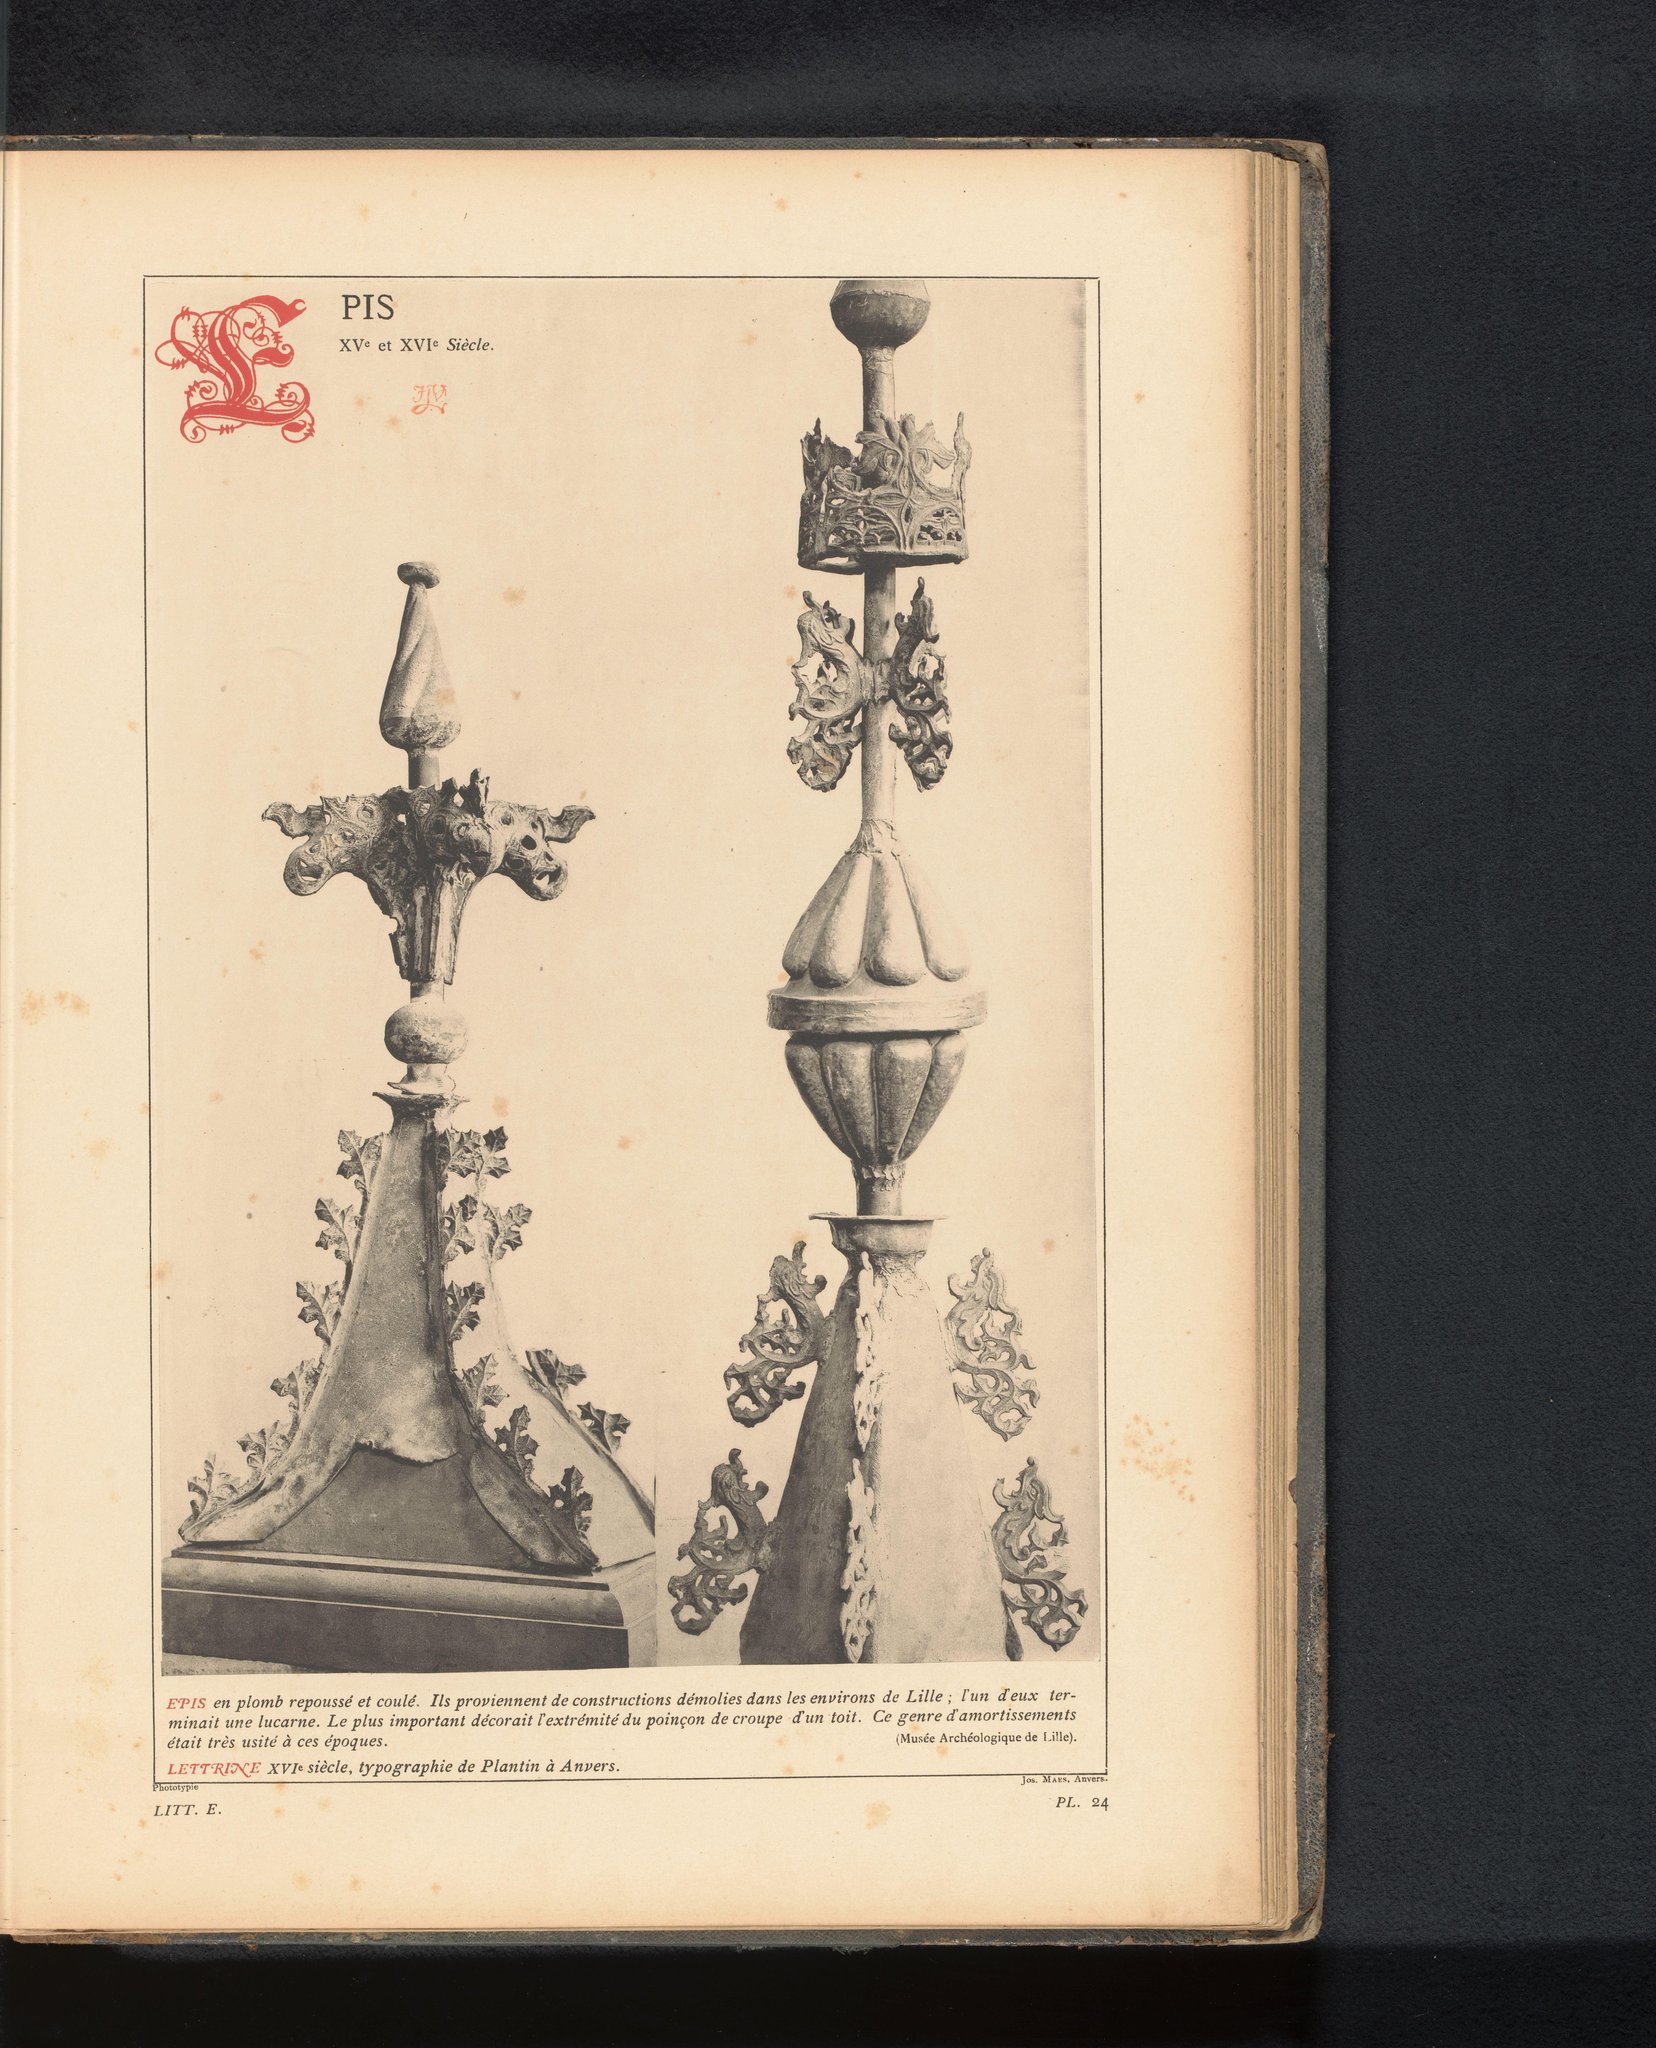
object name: photomechanical print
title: Twee dak decoraties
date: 1875-1880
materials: paper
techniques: photograph, photolithography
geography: antwerp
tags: decorated gable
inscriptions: monogram: ‘JJvY’, inscription: ‘EPIS en plomb (...)’, inscription: ‘LITT. E. - PL. 24’